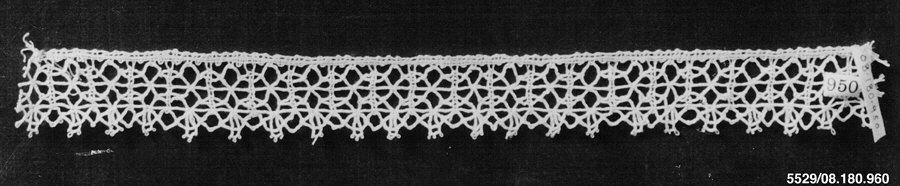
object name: fragment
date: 1801-1900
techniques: lace